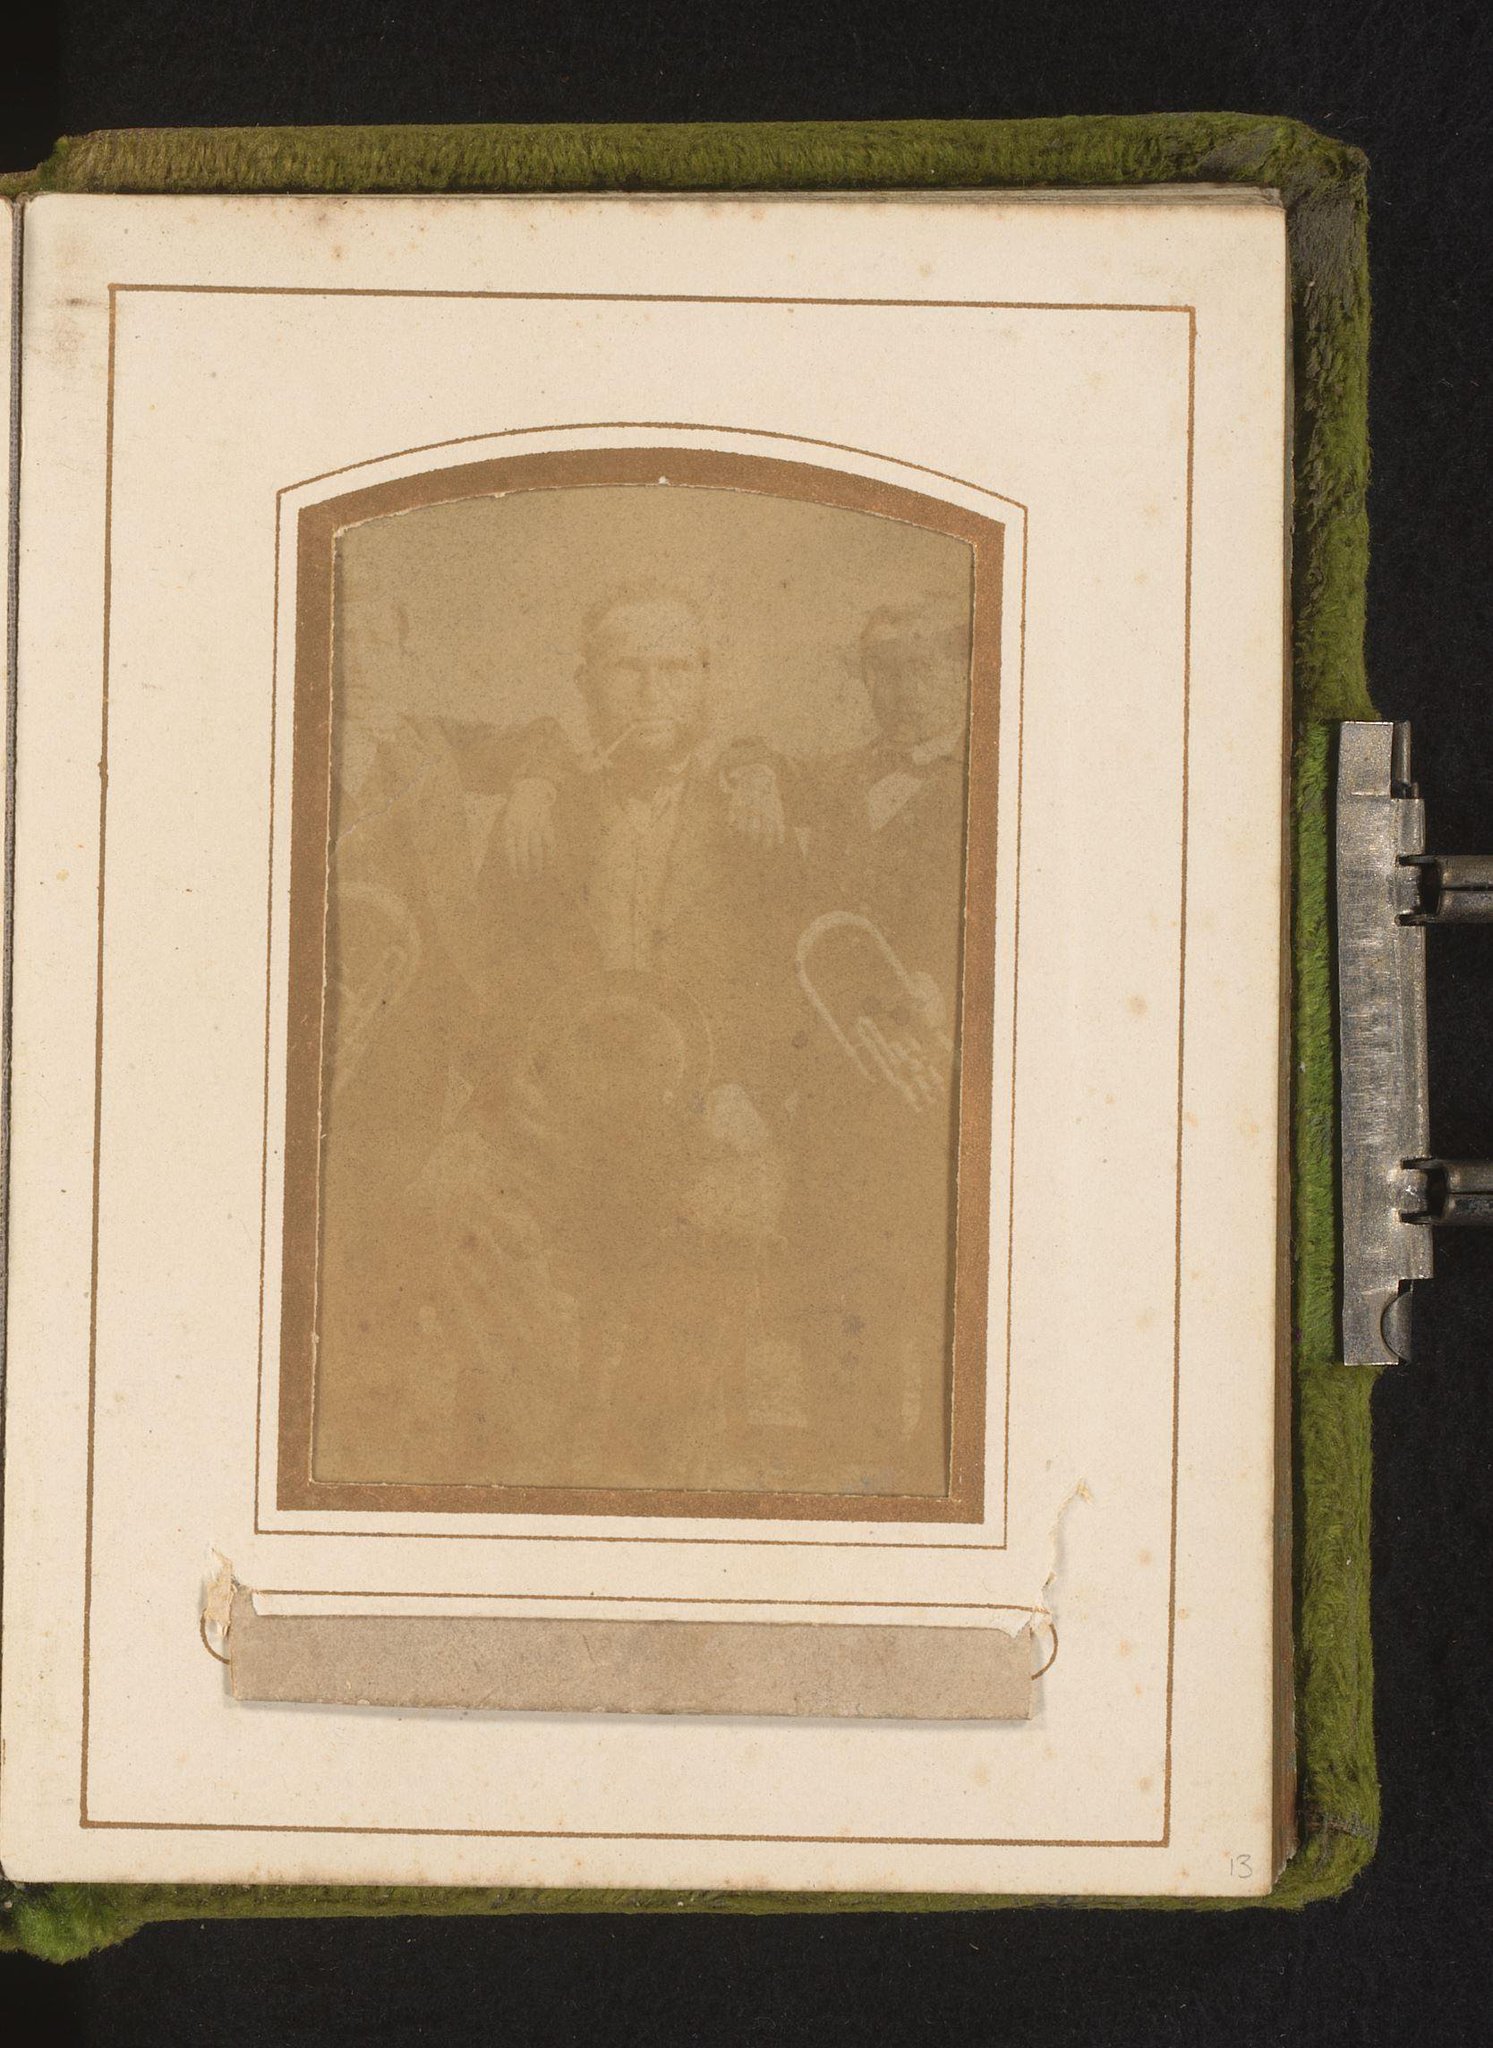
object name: photograph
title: Portret van een man en twee jongens met blaasinstrument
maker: Anonymous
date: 1860-1900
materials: cardboard, photographic support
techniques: albumen print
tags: boy (child between toddler and youth), adult man, historical persons, wind instruments